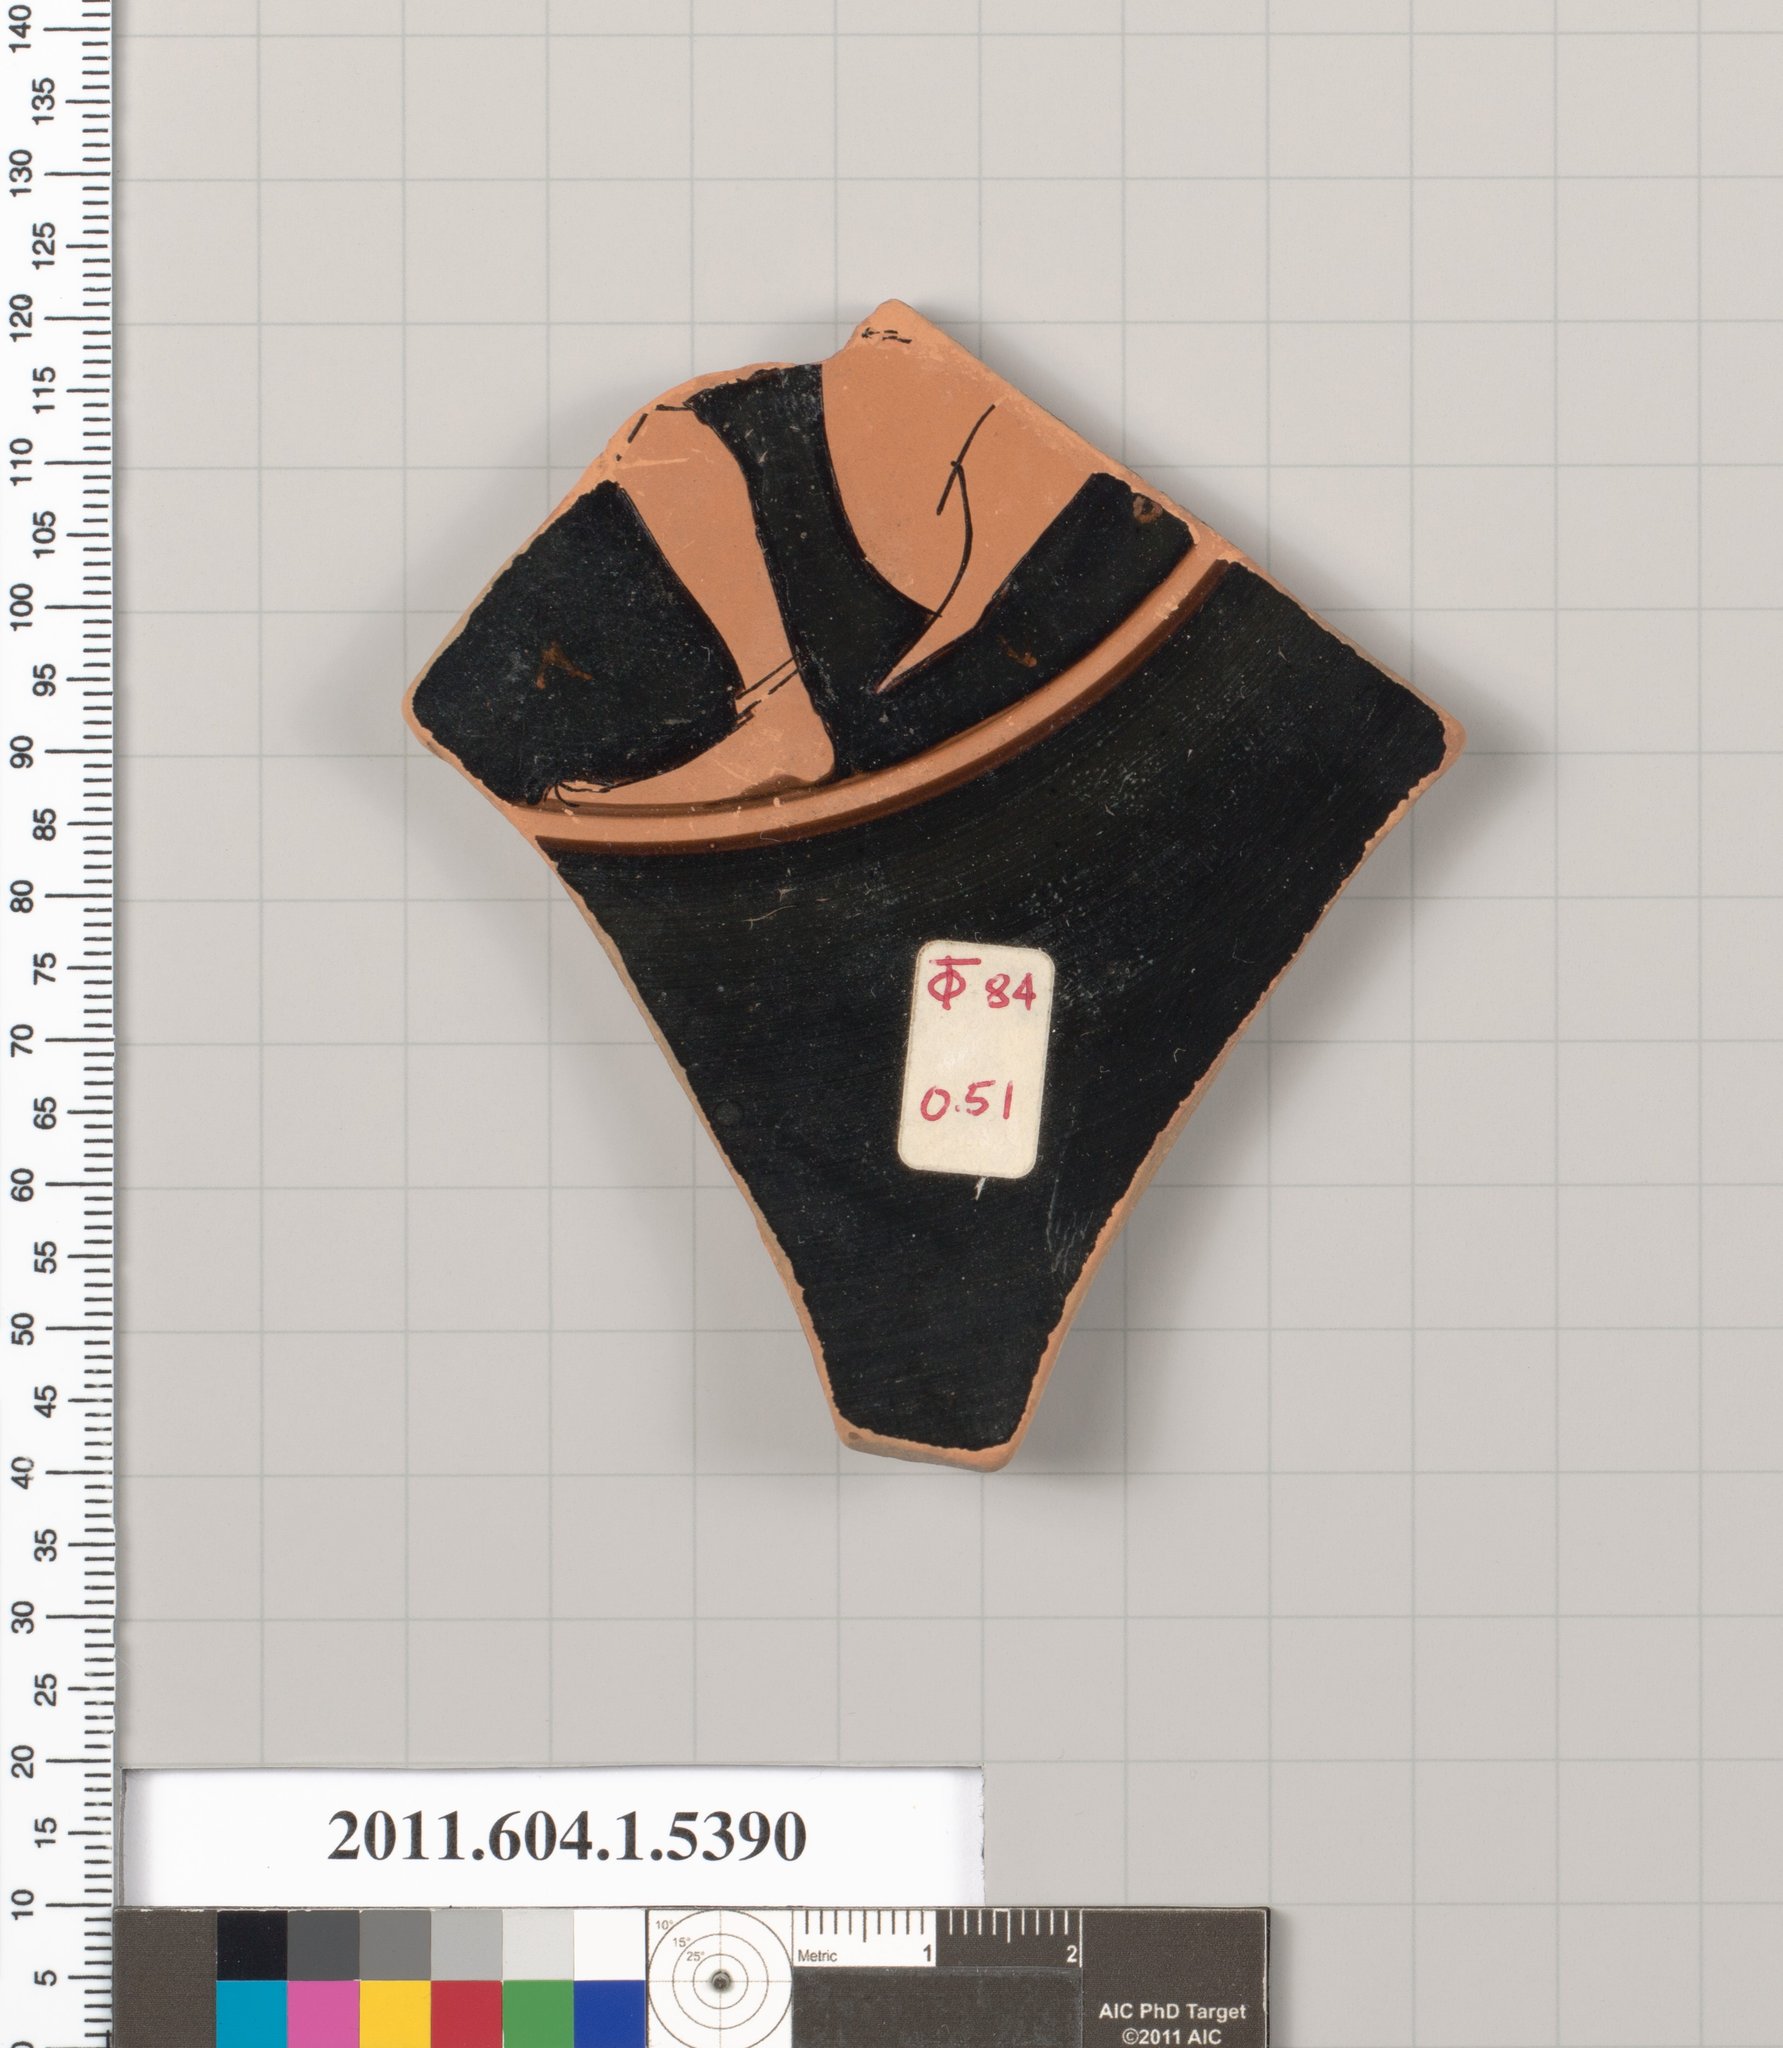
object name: kylix fragment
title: Terracotta fragment of a kylix (drinking cup)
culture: greek, attic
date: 510-500 BCE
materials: terracotta